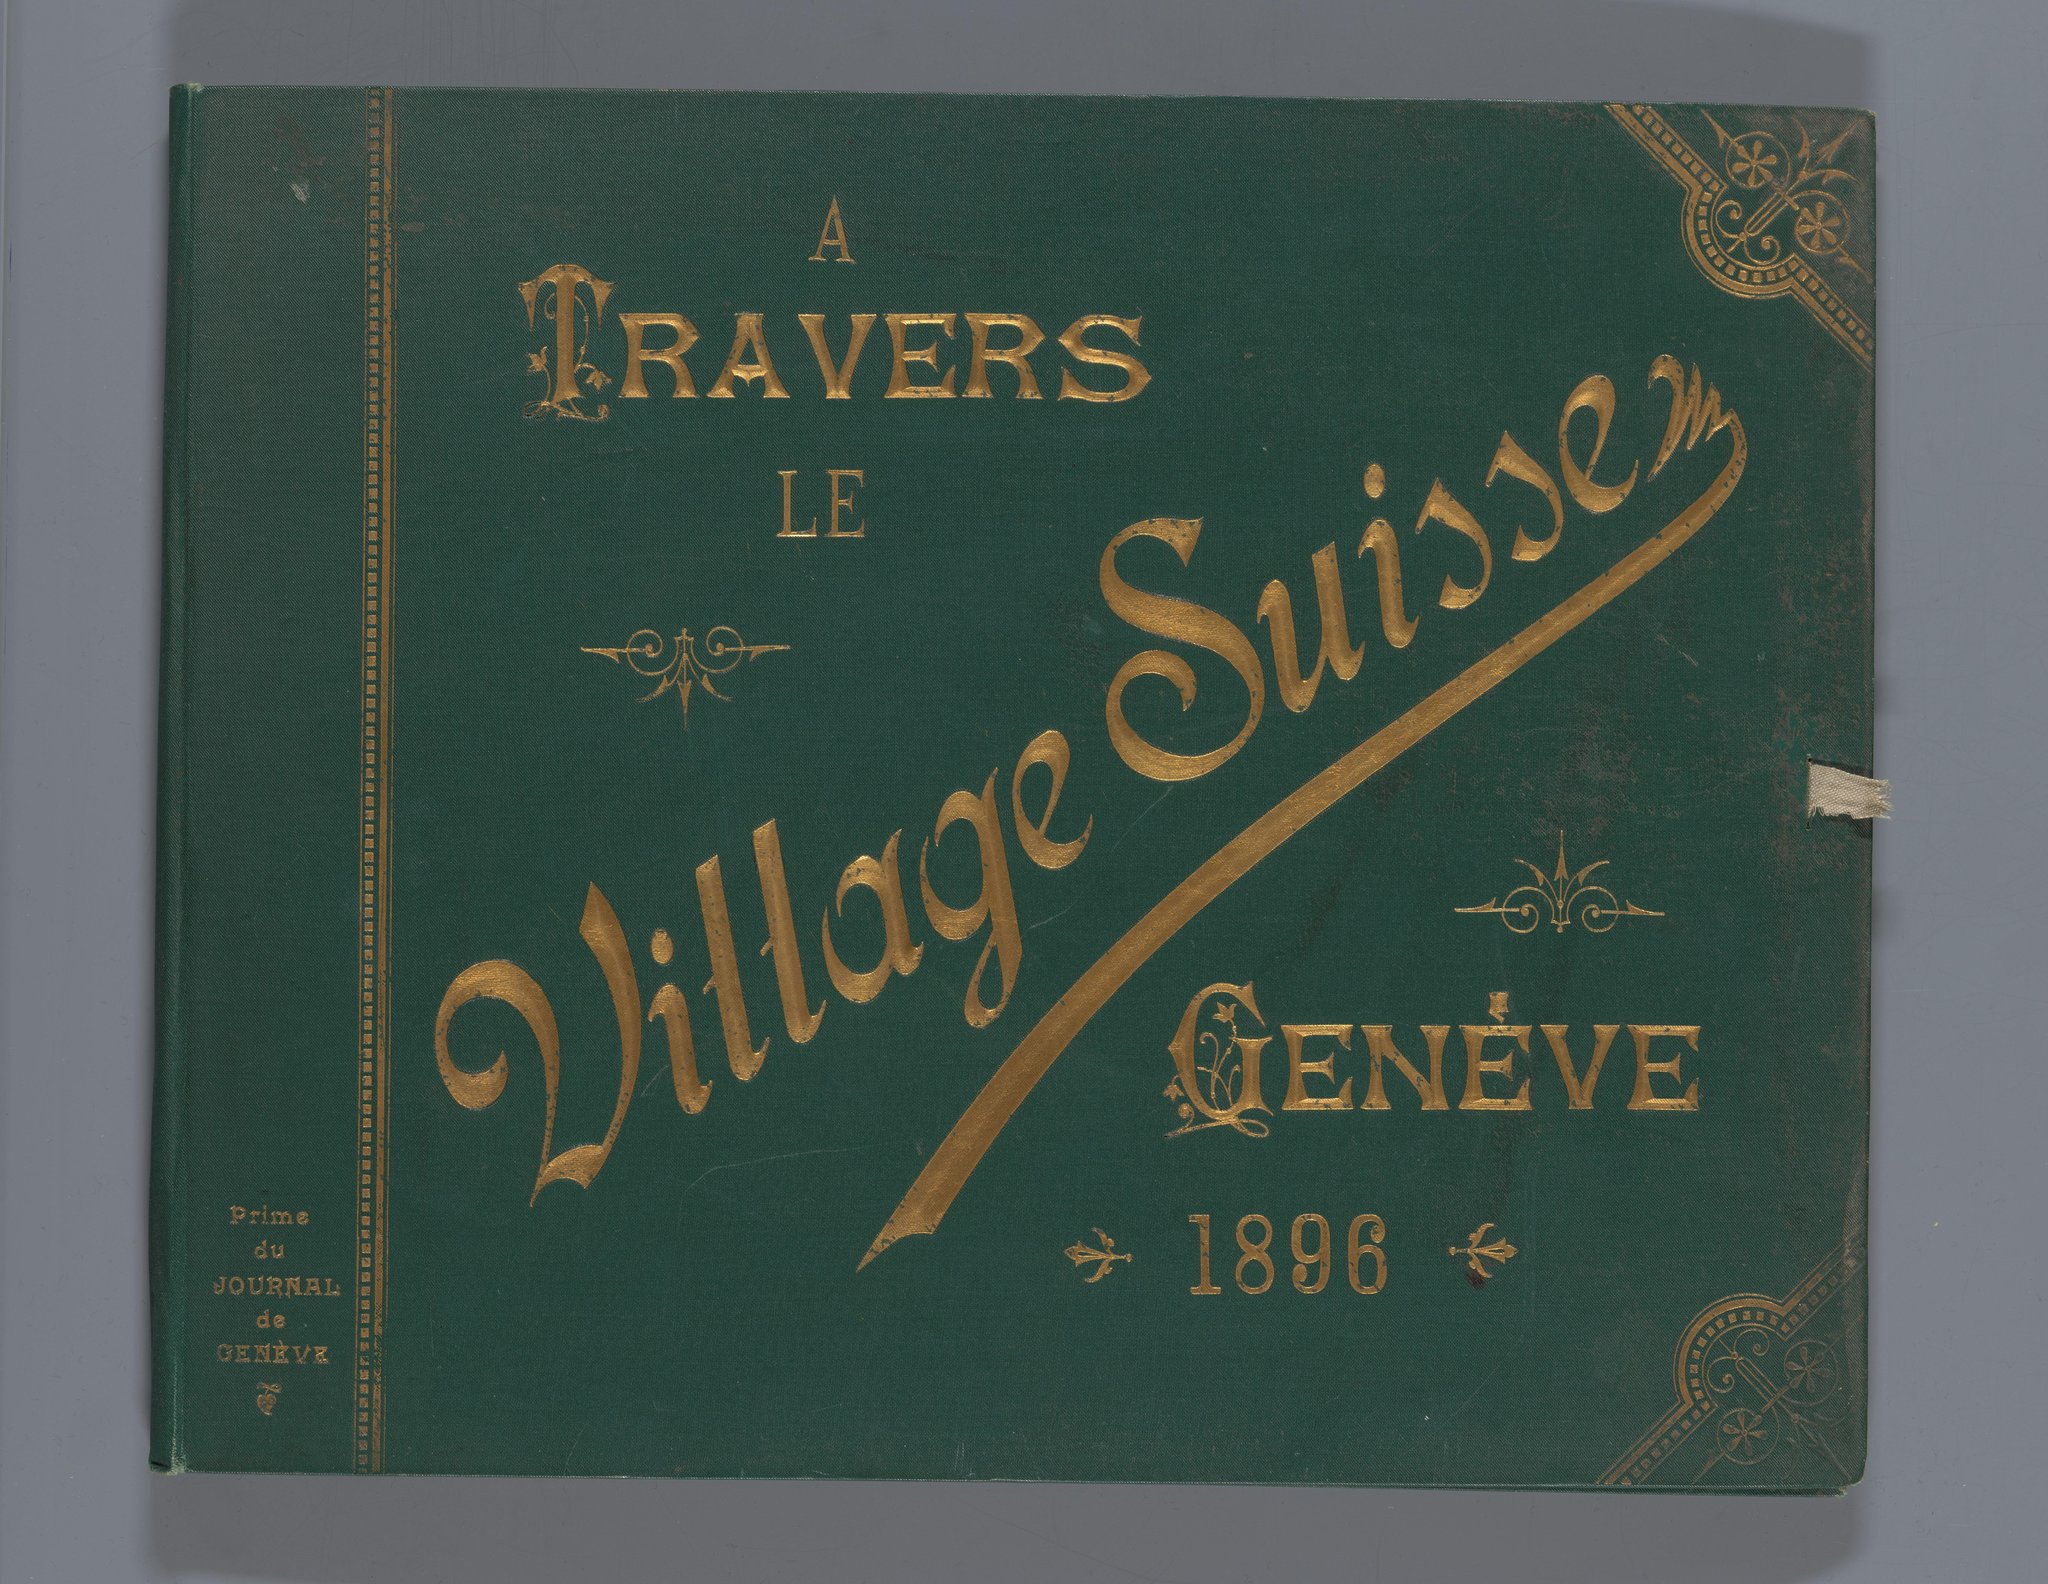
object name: wrapper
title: A travers le village suisse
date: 1896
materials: linen, paper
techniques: photograph, printing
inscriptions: date: ‘NOV 1997’, inscription: ‘A travers le village Suisse’, annotation: ‘180-’